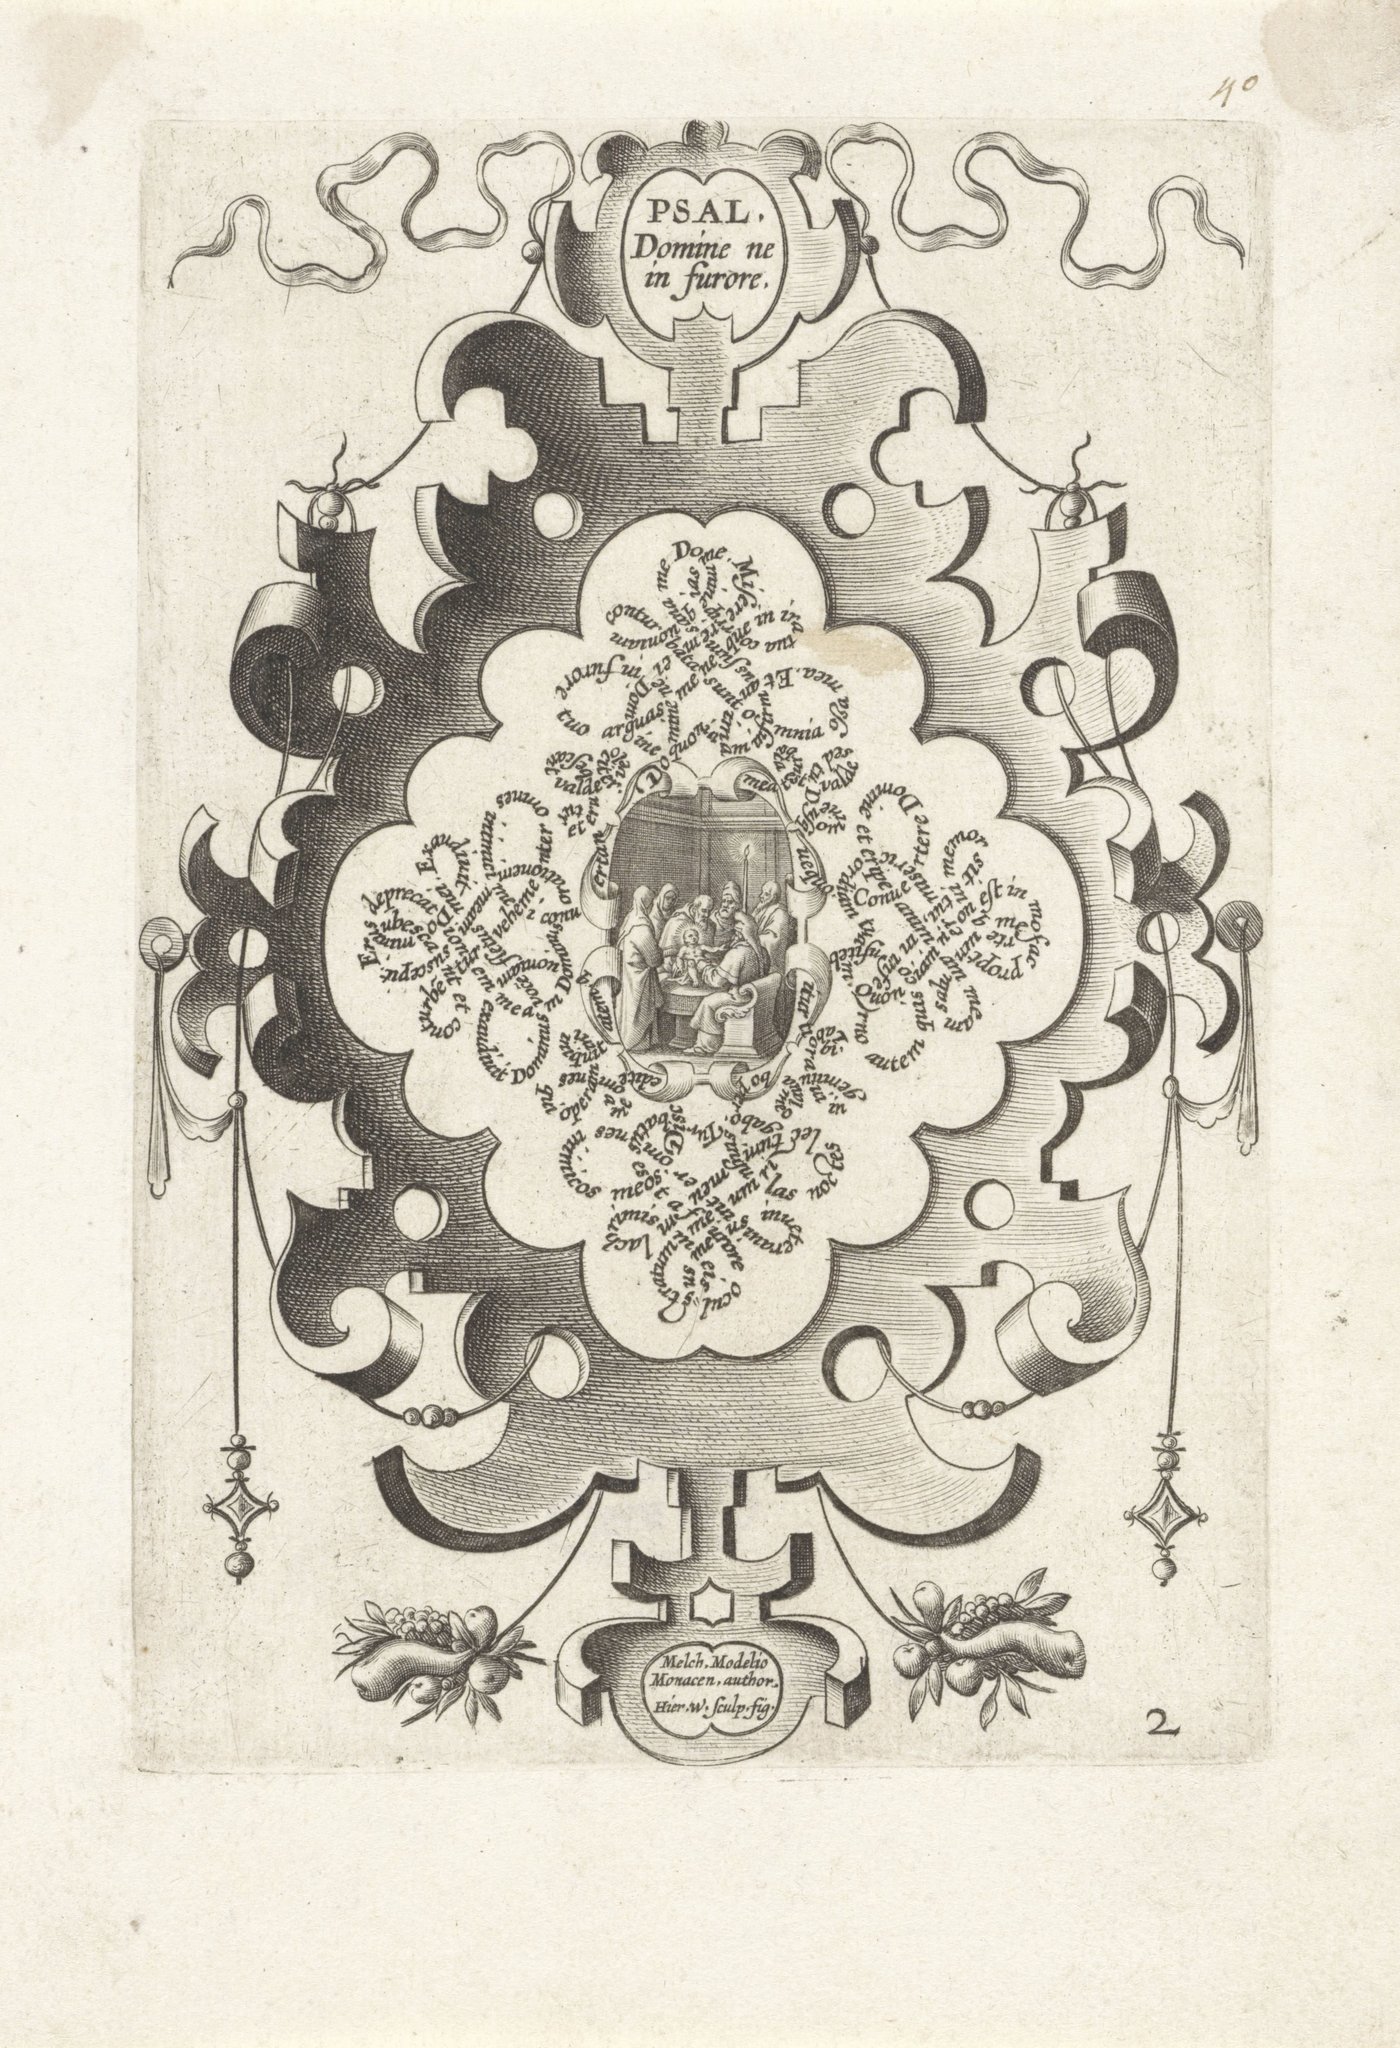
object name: ornament print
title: Septem Psalmi Davidici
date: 1608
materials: paper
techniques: engraving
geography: antwerp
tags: ornament ~ cartouche, the book of psalms, circumcision of the christ-child by the priest in the temple (luke 2:21)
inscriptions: collector's mark: Lugt 2228, number: ‘40’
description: Het Christuskind wordt op een altaar in de tempel besneden door een priester. Maria en anderen kijken toe. De voorstelling is gevat in een cartouche en geplaatst te midden van de in een knooppatroon gedrukte psalmtekst.